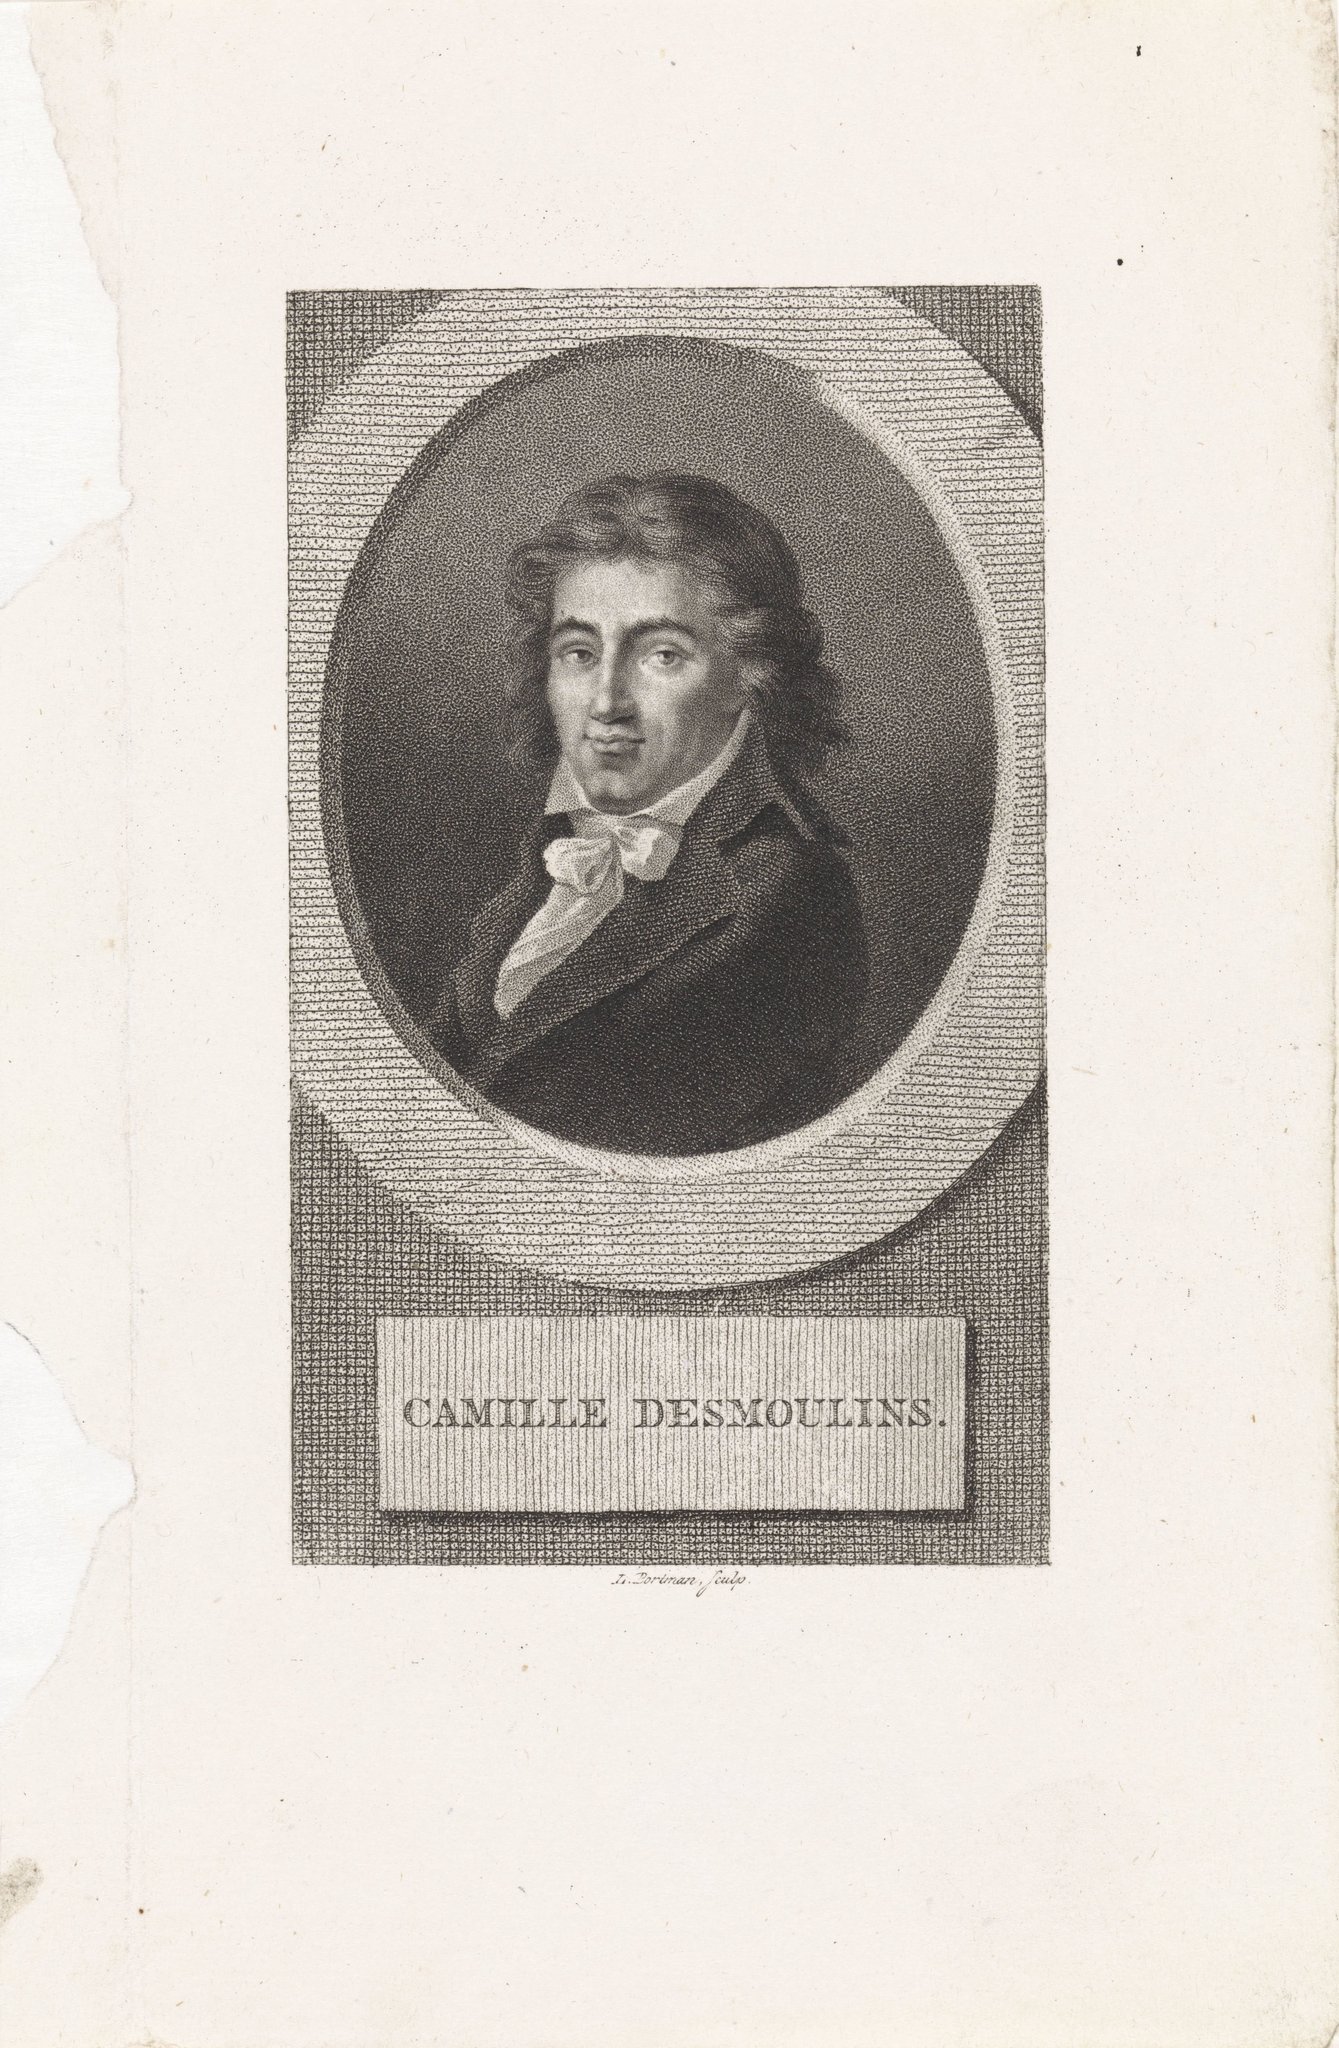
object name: print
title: Portret van de Franse schrijver en politicus Camille Desmoulins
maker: ludwig gottlieb portman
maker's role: print maker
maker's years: 1772-1828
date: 1804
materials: paper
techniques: etching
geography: amsterdam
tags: politician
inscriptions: collector's mark: Lugt 2228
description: Prent ook gebruikt als illustratie in: Tafereelen van de staatsomwenteling in Frankrijk, deel 19, p. 82. Amsterdam: Johannes Allart, 1804.